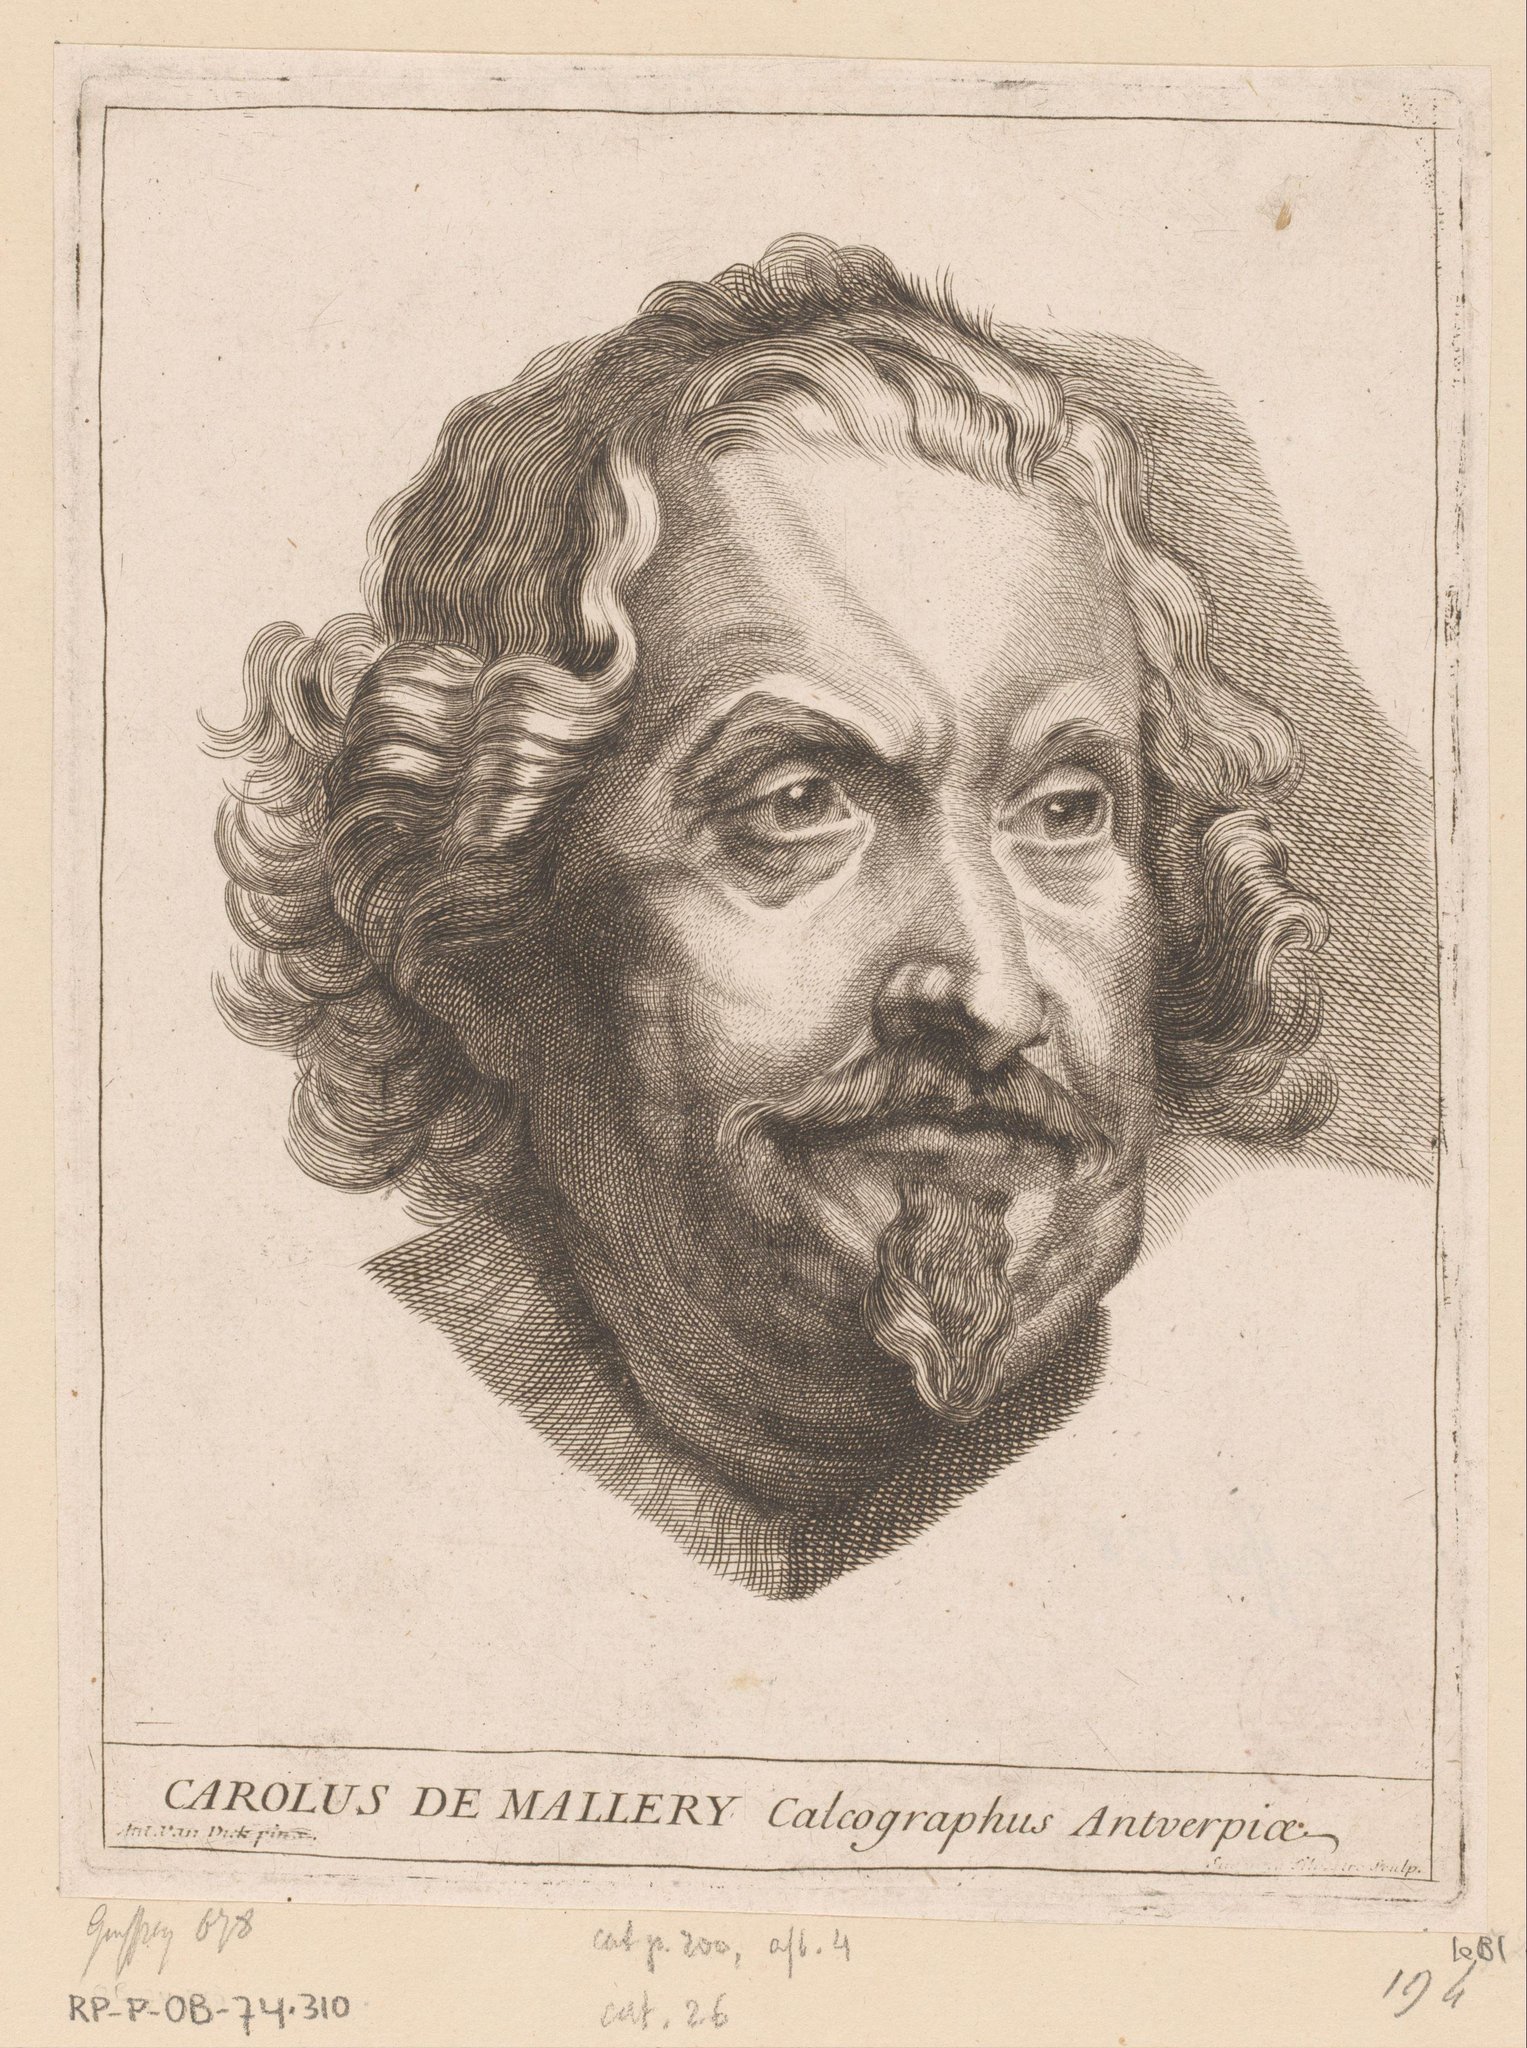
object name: print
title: Portret van Karel van Mallery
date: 1704-1738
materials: paper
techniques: engraving, etching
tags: antwerp, print maker, publisher, karel van mallery, historical persons, portrait, self-portrait of graphic artist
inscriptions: collector's mark: Lugt 240